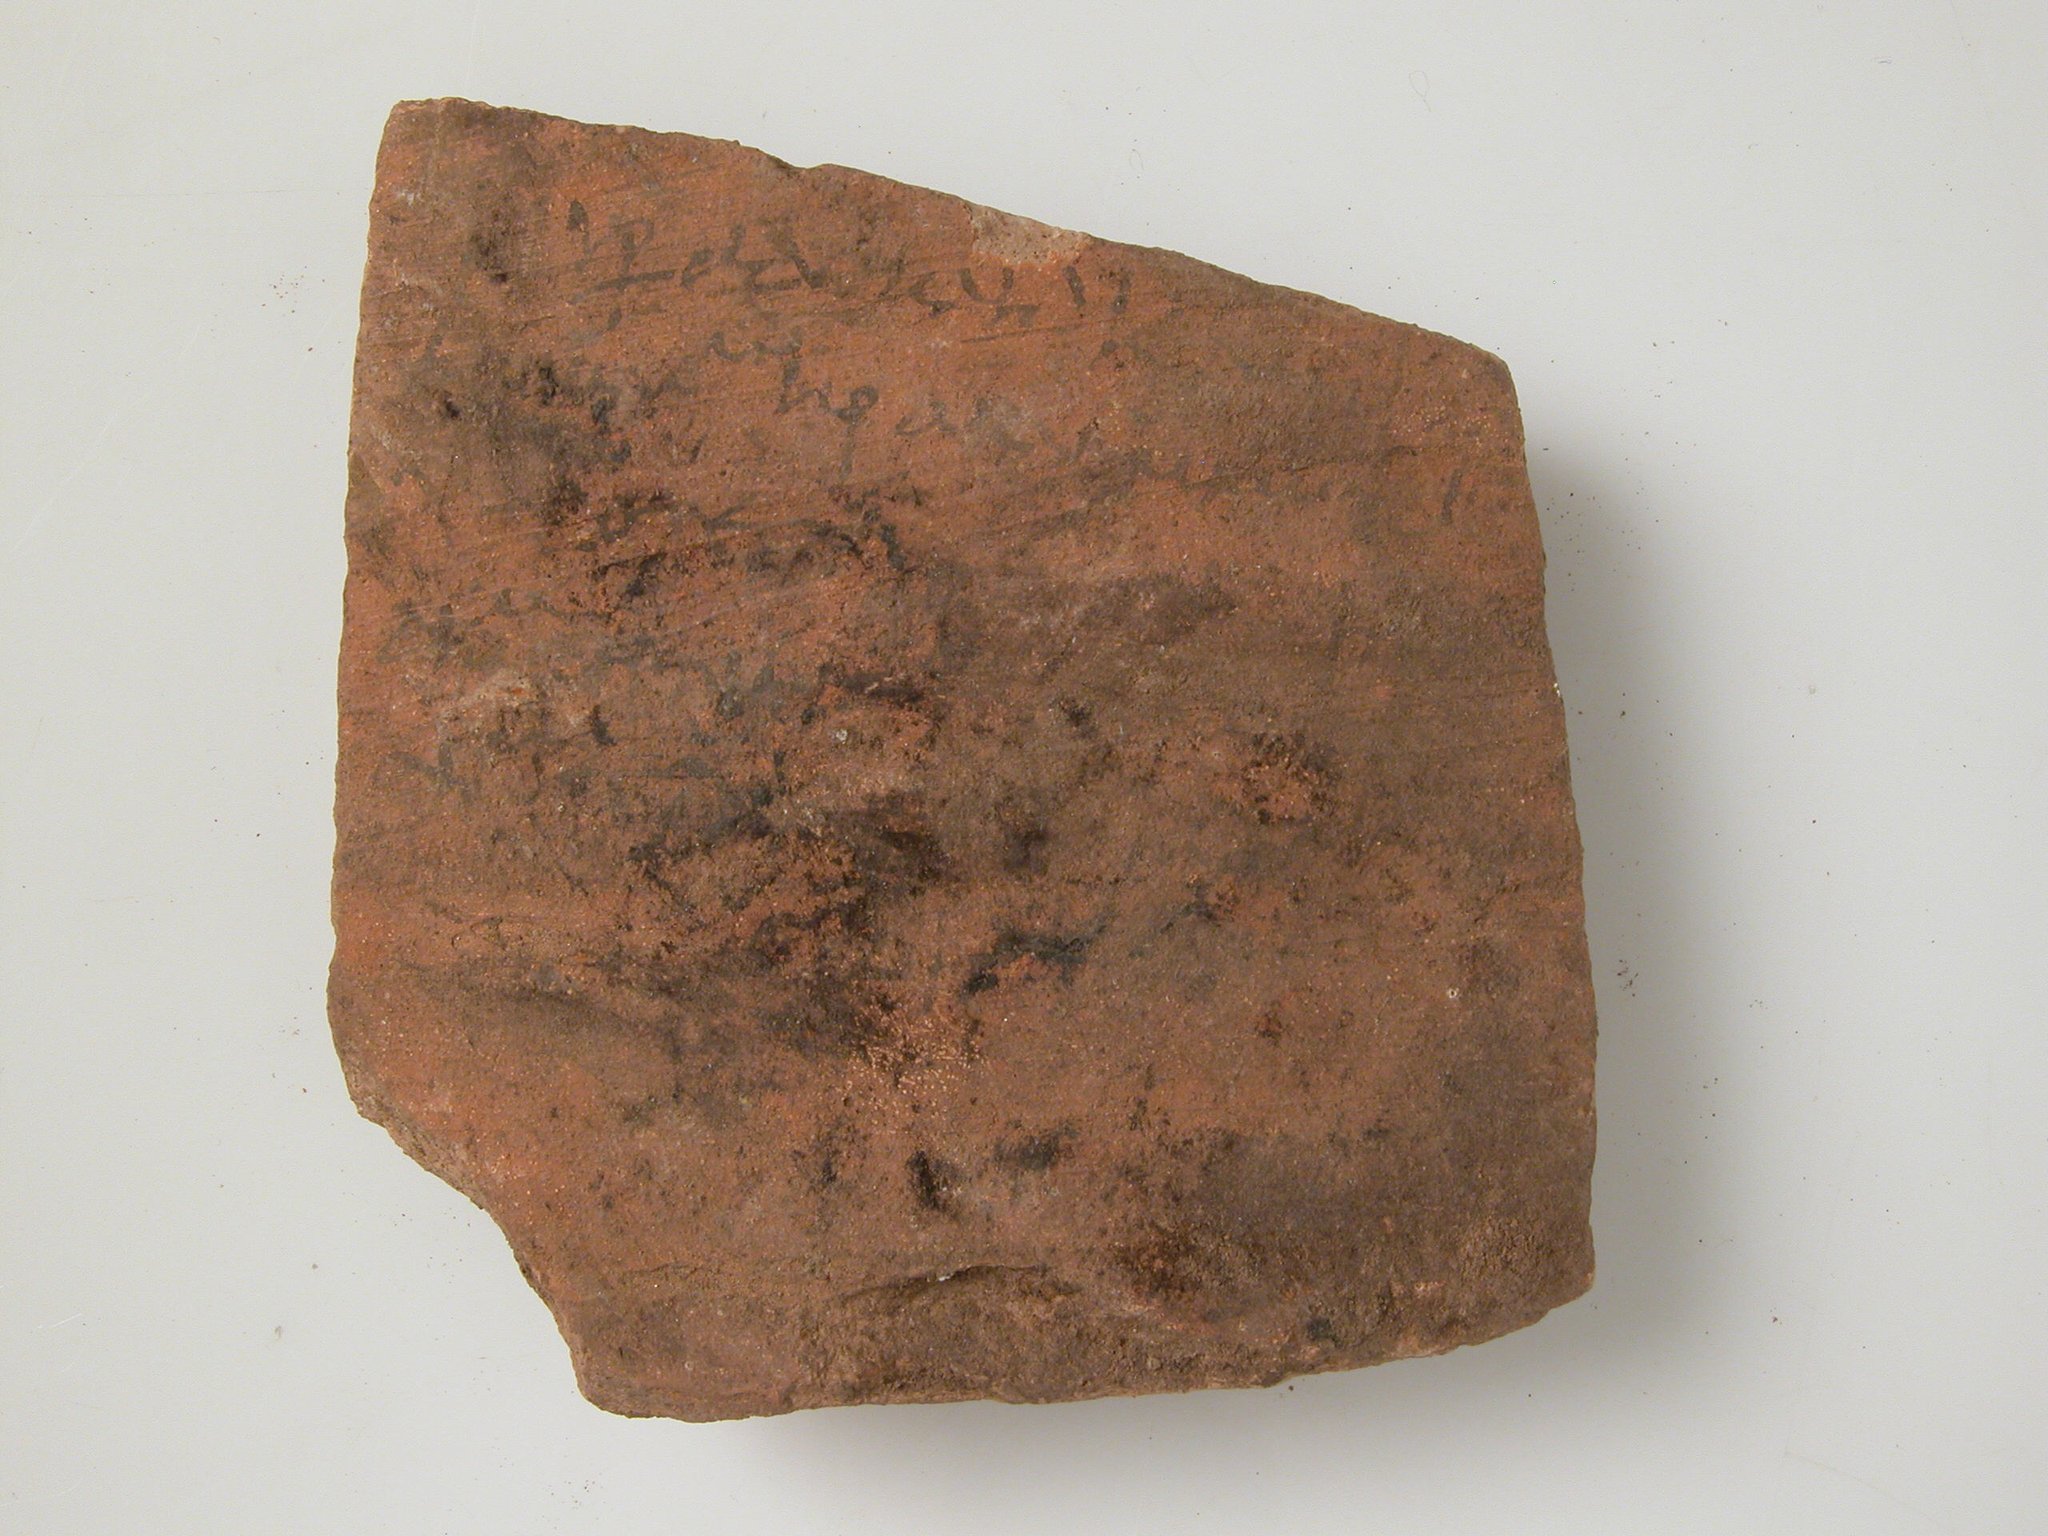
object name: ostrakon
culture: coptic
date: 301-700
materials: ink, pottery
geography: egypt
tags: documents